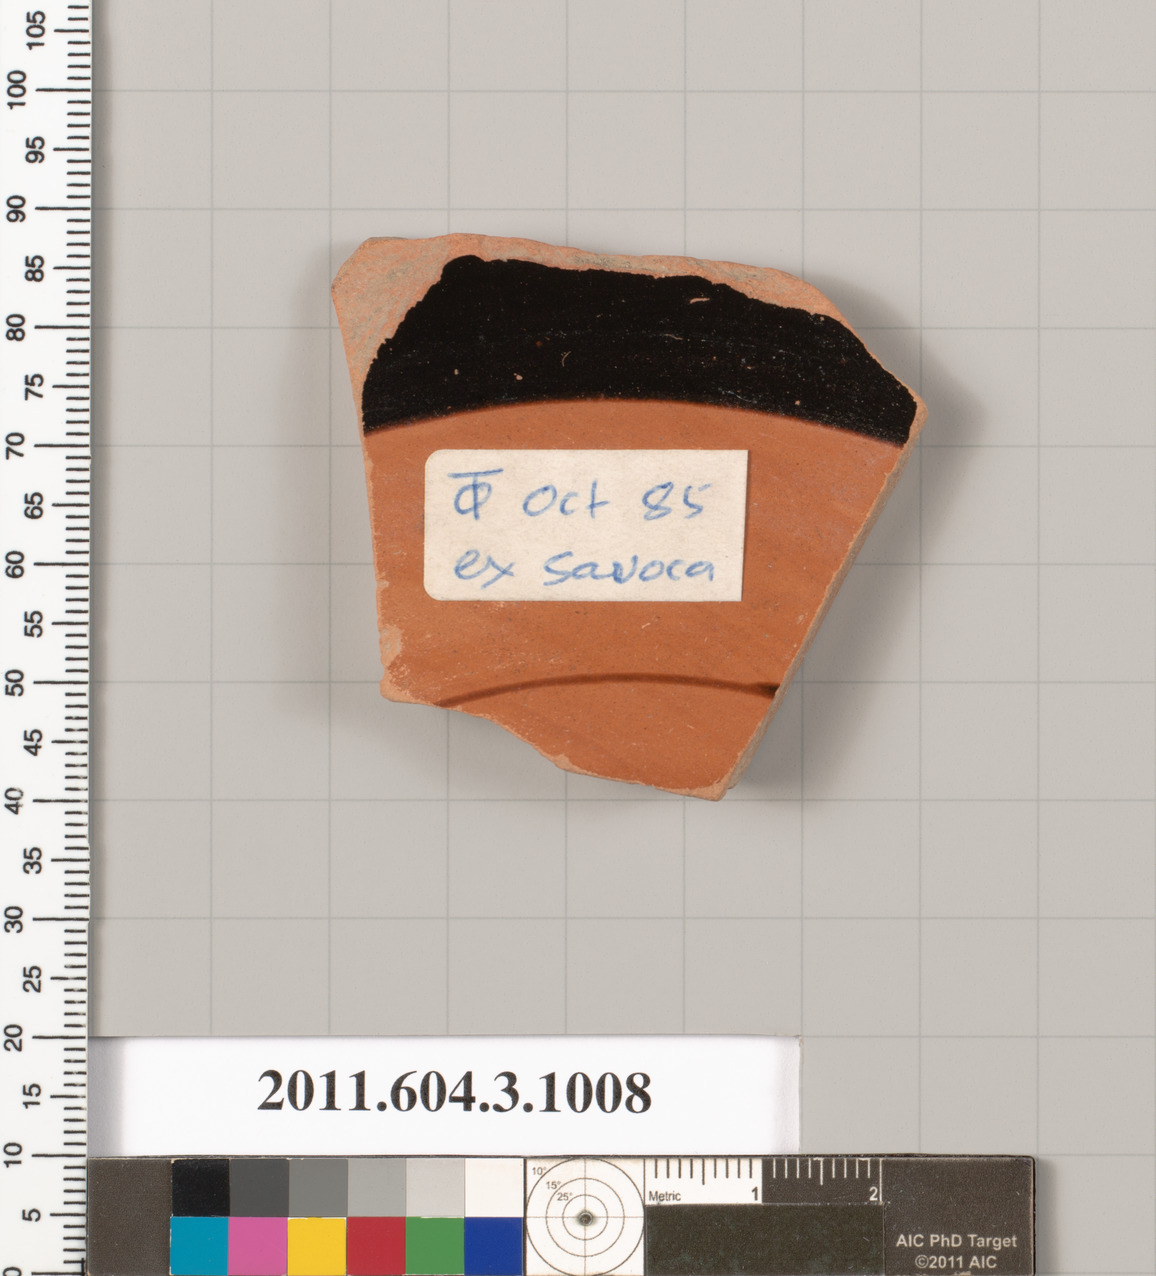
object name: plate fragment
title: Terracotta fragment of a plate?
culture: greek, attic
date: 600-501 BCE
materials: terracotta